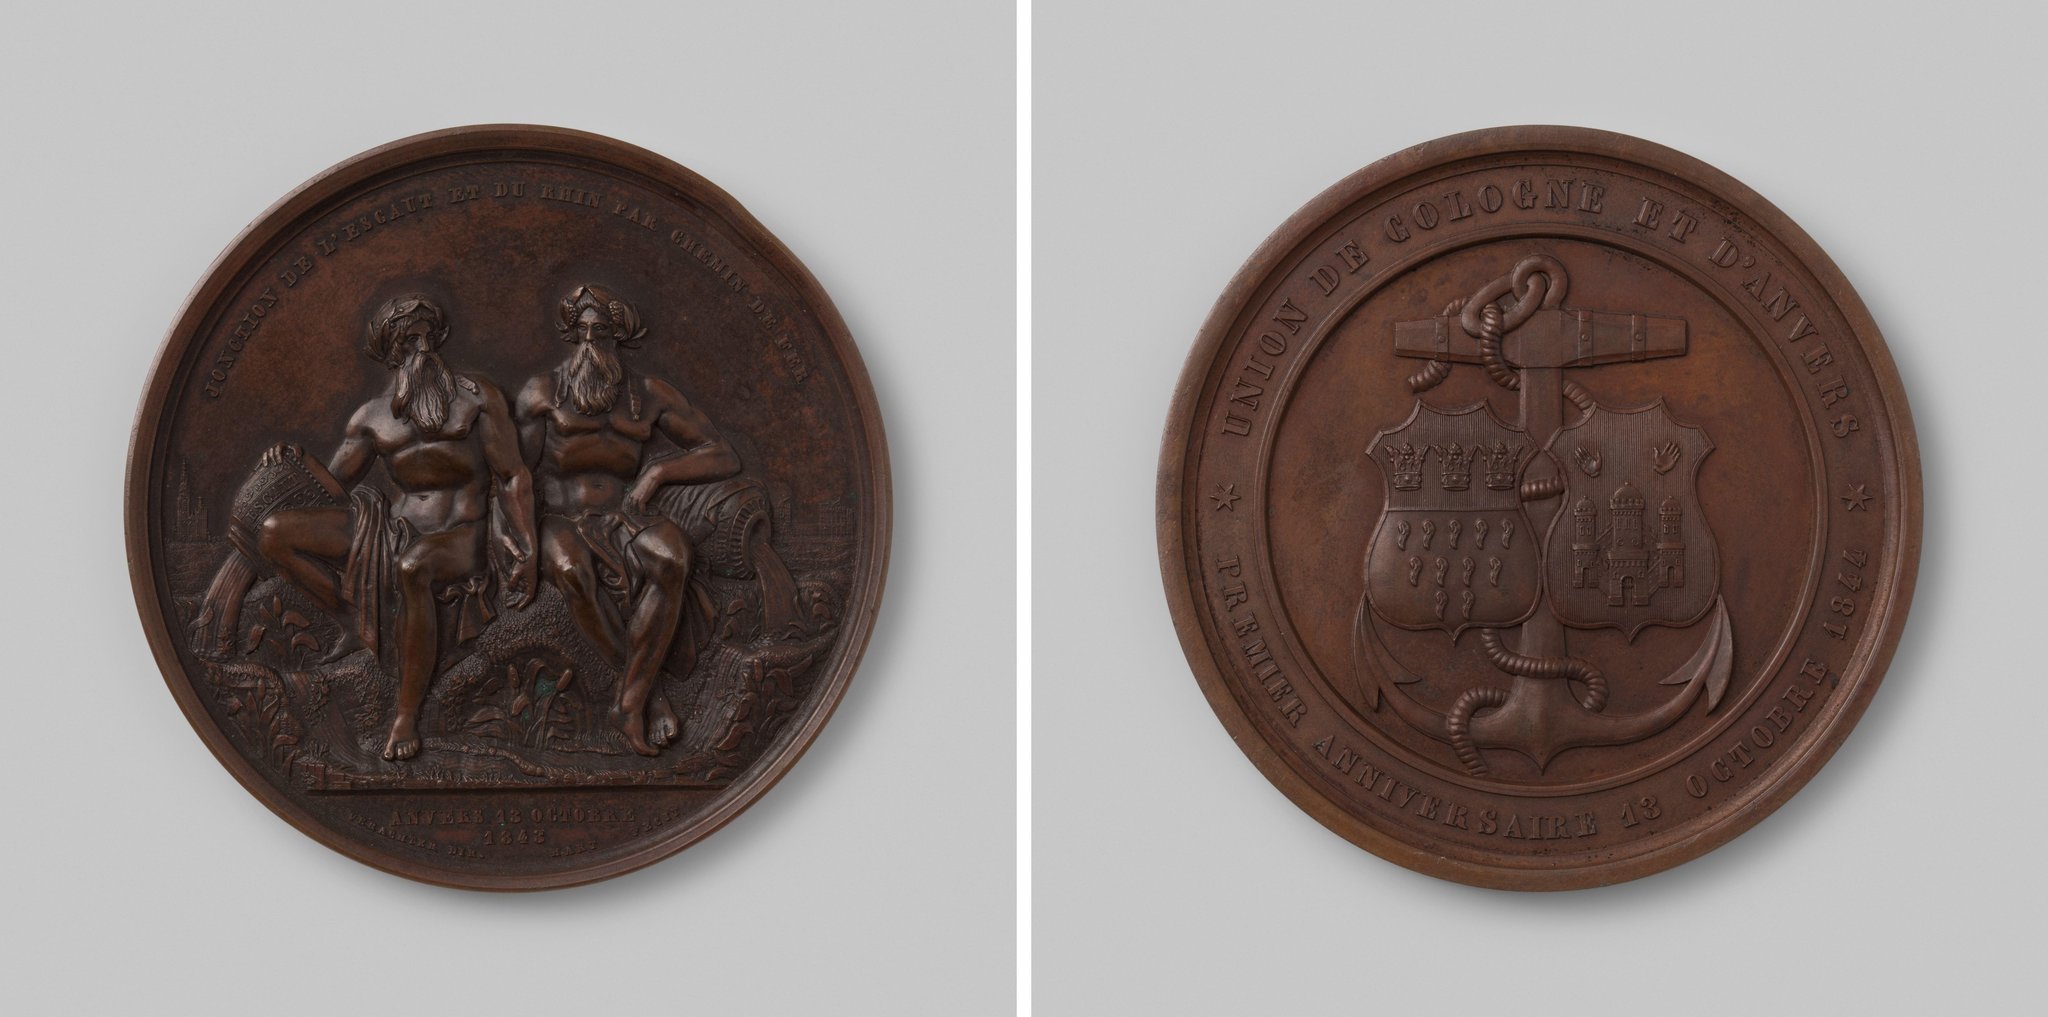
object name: history medal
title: Opening van de spoorweg Antwerpen-Keulen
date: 1844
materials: bronze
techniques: striking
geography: brussels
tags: antwerp, cologne